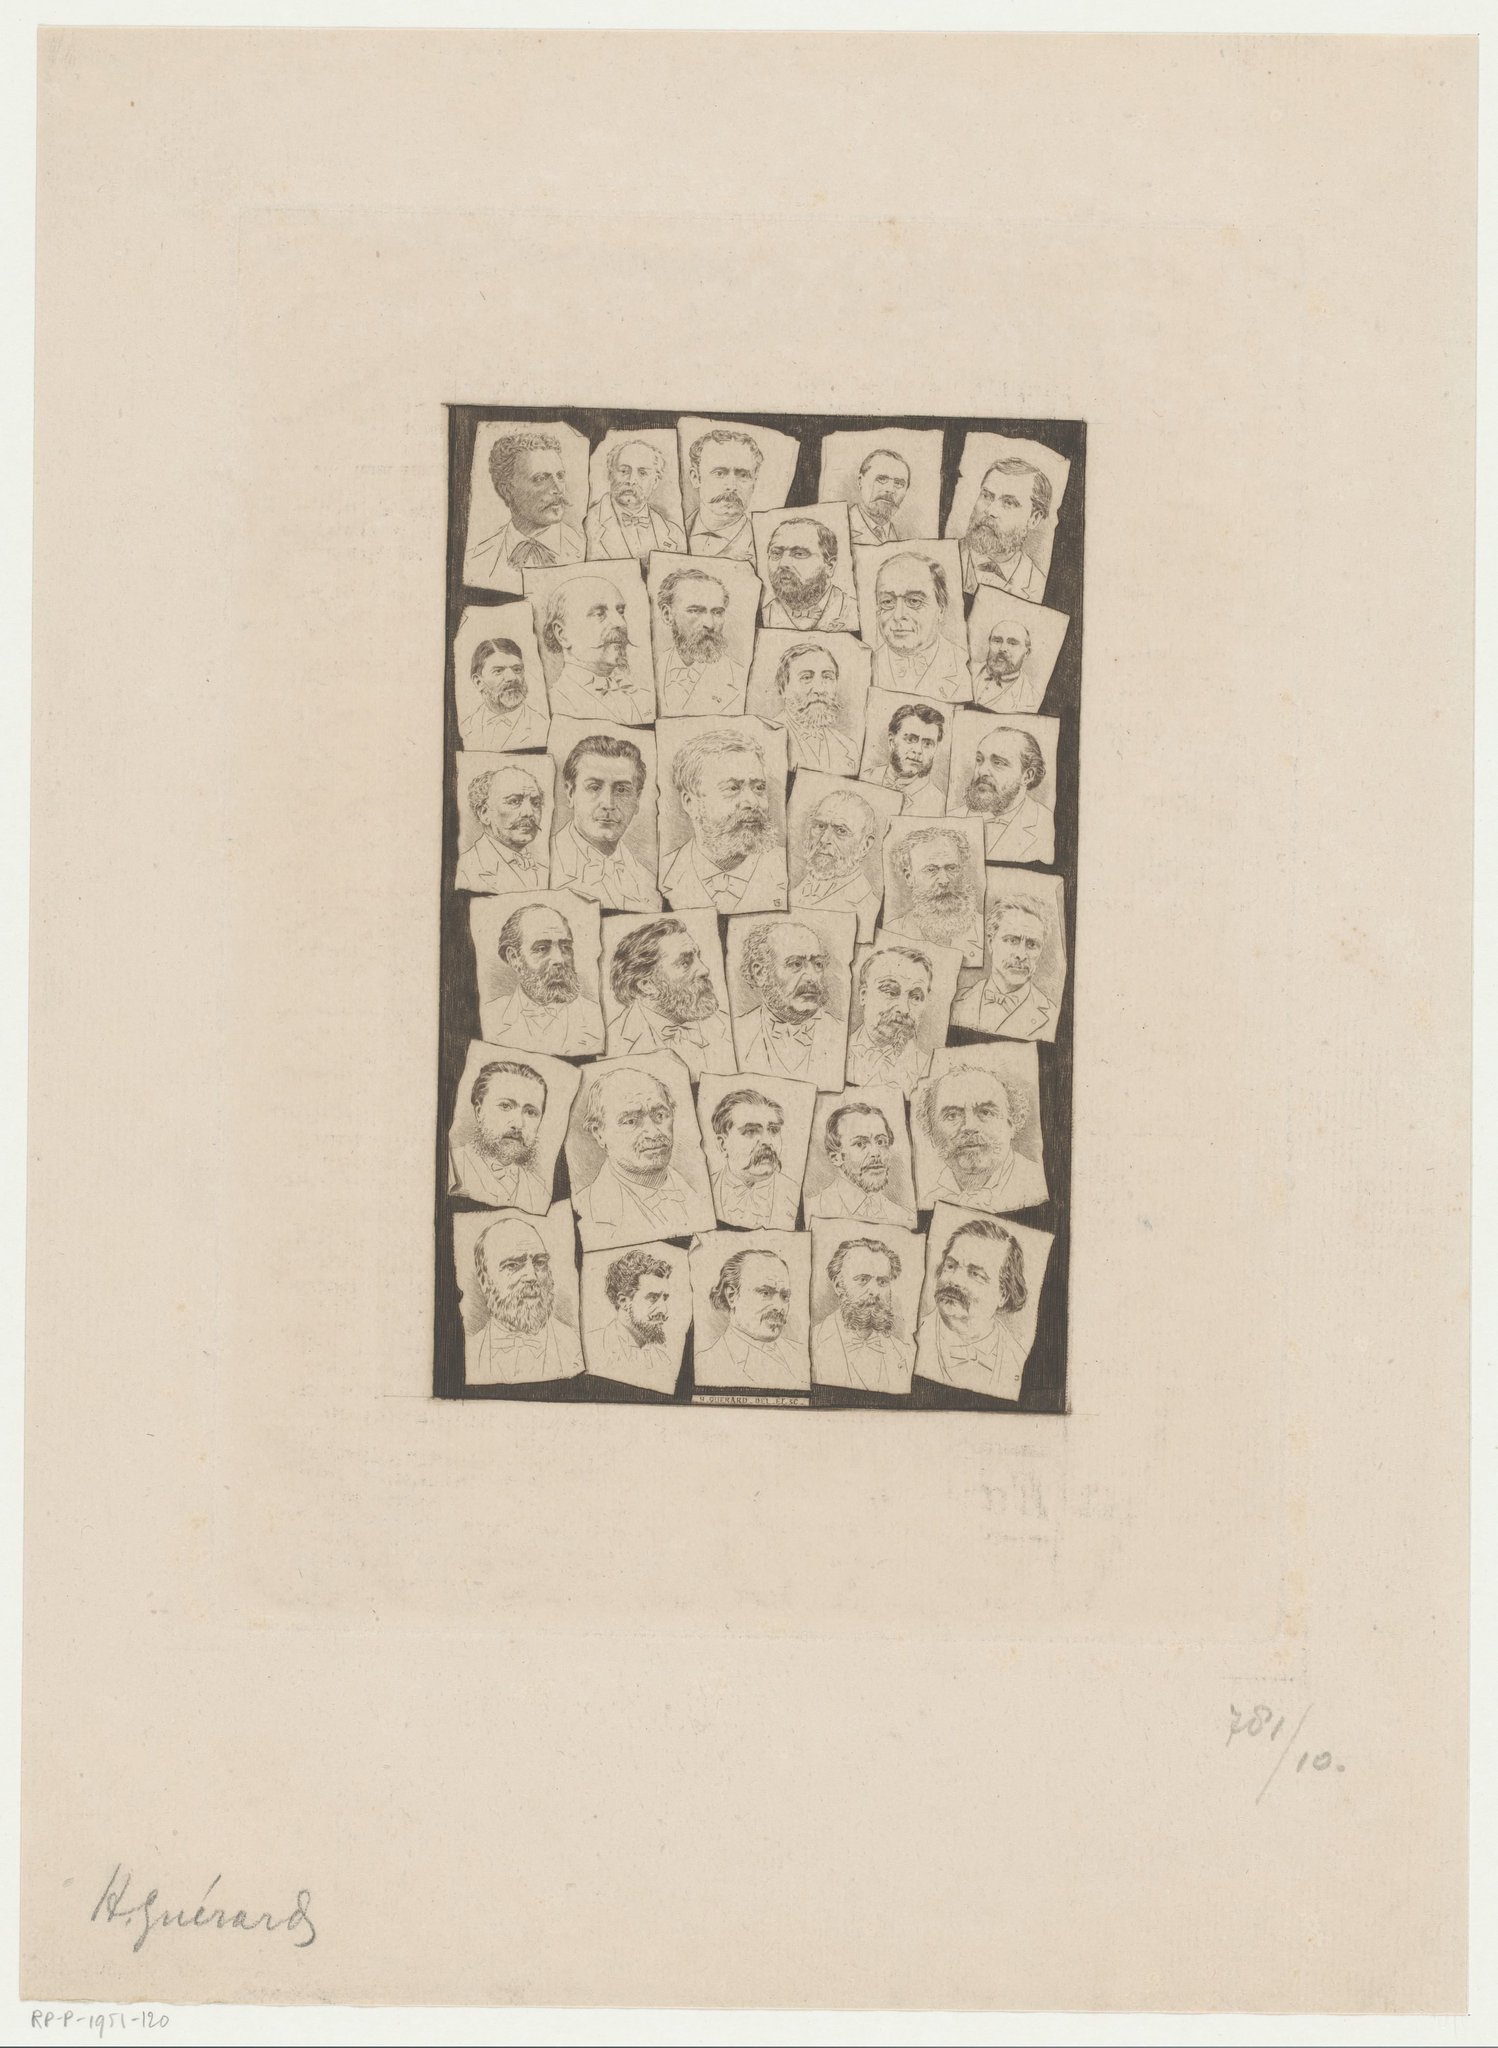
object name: print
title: Portretten van leden van de Société des gens de lettres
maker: henri charles guérard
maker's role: print maker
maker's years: 1846-1897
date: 1883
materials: paper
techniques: etching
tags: historical persons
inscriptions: collector's mark: Lugt 2228